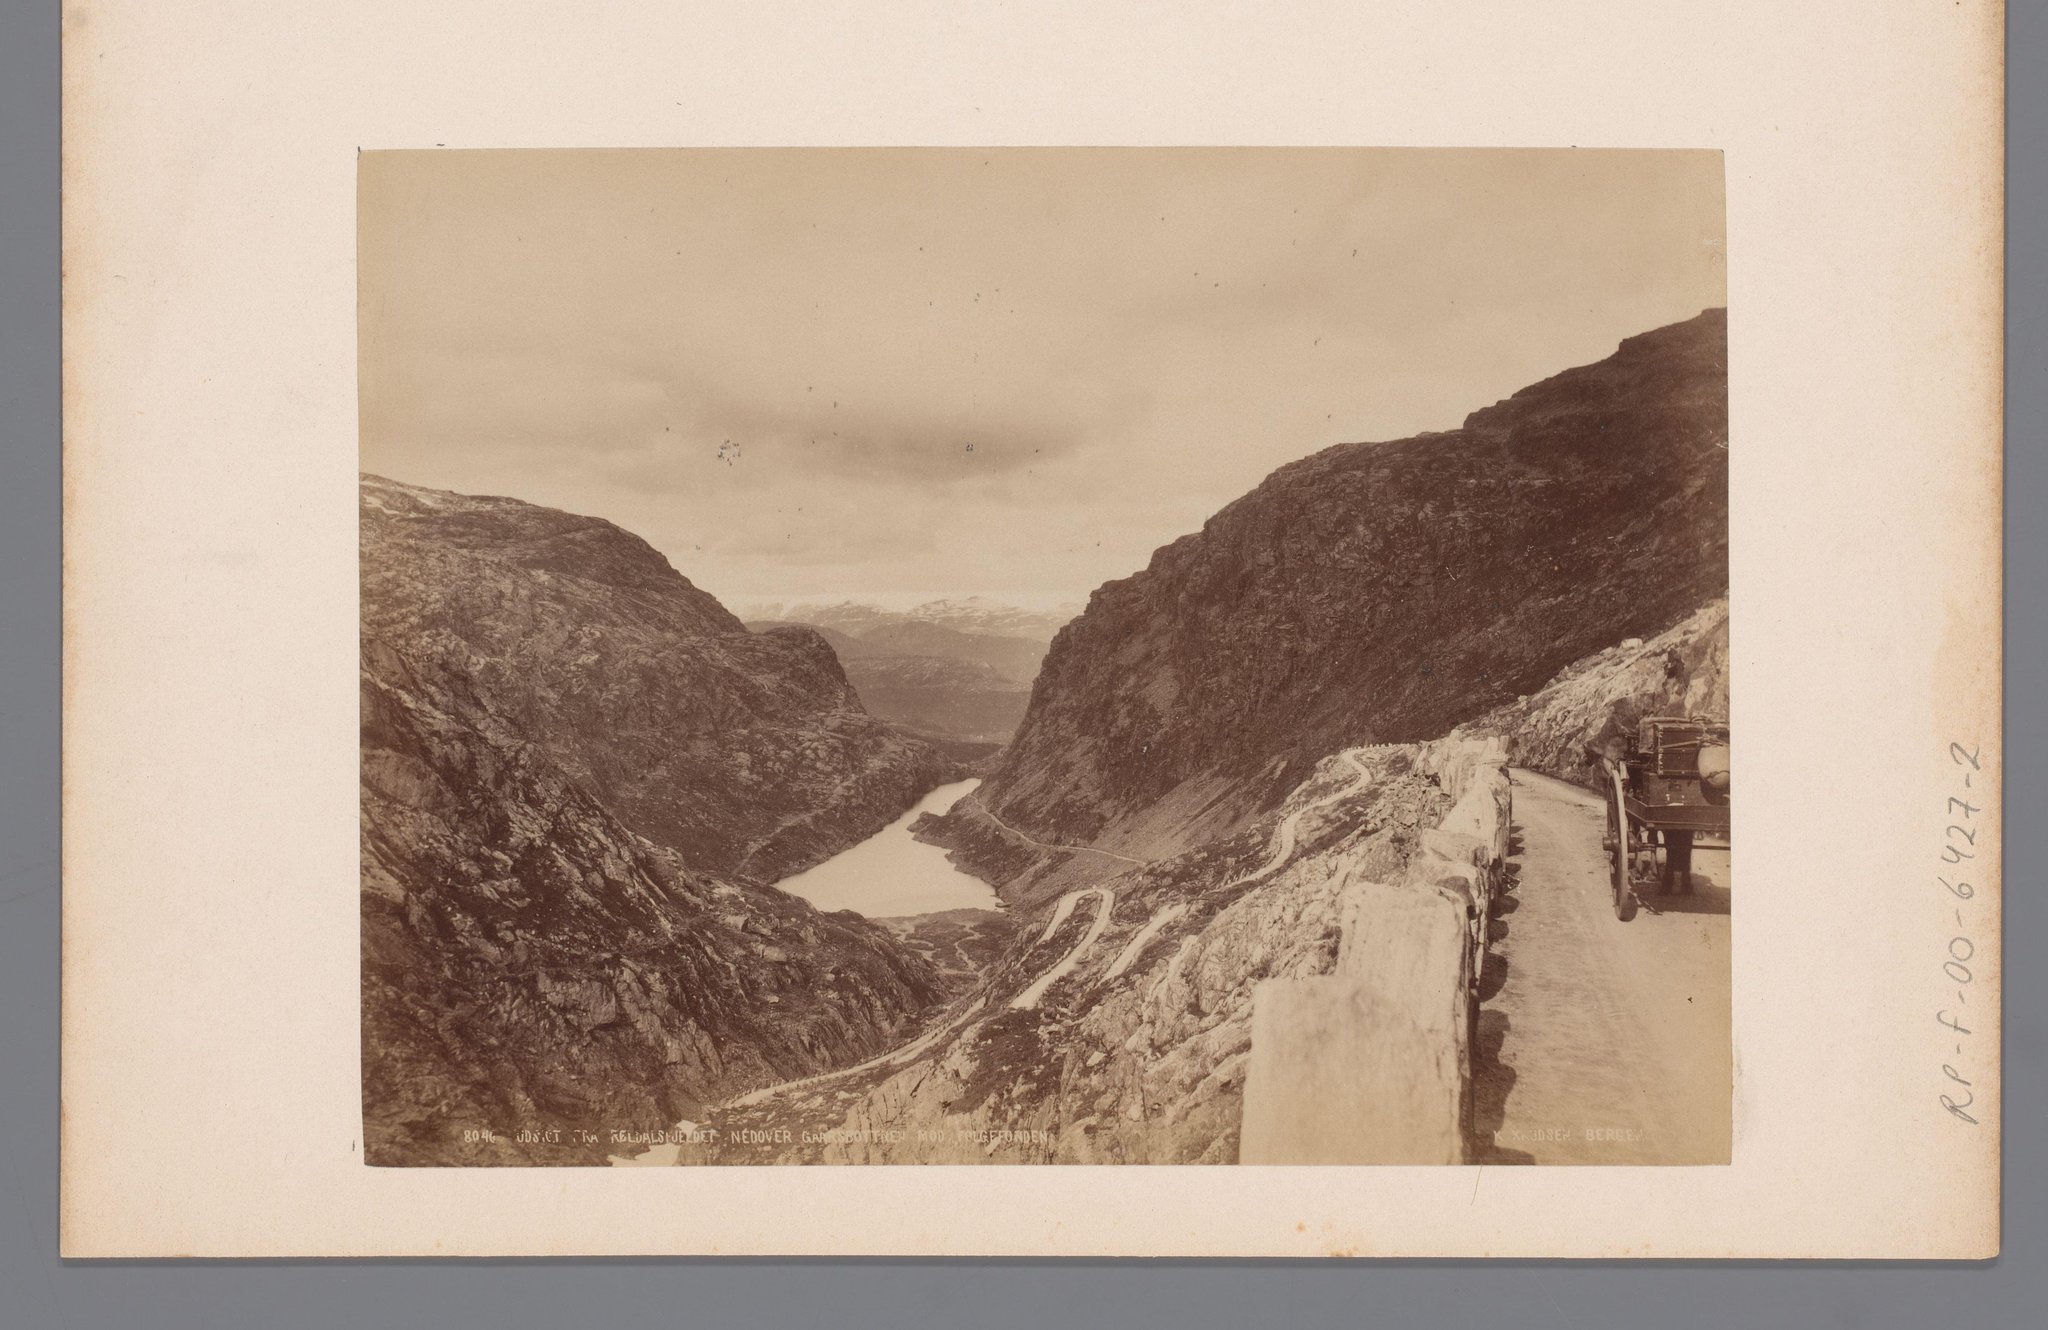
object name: photograph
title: Udisgt fra Reldalsfjeldet nedover gaarsbottnen mod folgffonden, Noorwegen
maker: knud knudsen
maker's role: fotograaf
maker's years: 1832-1915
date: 1880-1900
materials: cardboard, photographic support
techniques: albumen print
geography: bergen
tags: norway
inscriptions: inscription: ‘K. Knudsen, Bergen.’, inscription: ‘Udisgt fra Reldalsfjeldet nedover gaarsbottnen mod folgffonden’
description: Uitzicht over een diep dal met bergen eromheen, genomen vanuit een weg met daarnaast een kar. Fotograaf lijkt te zijn afgestapt.